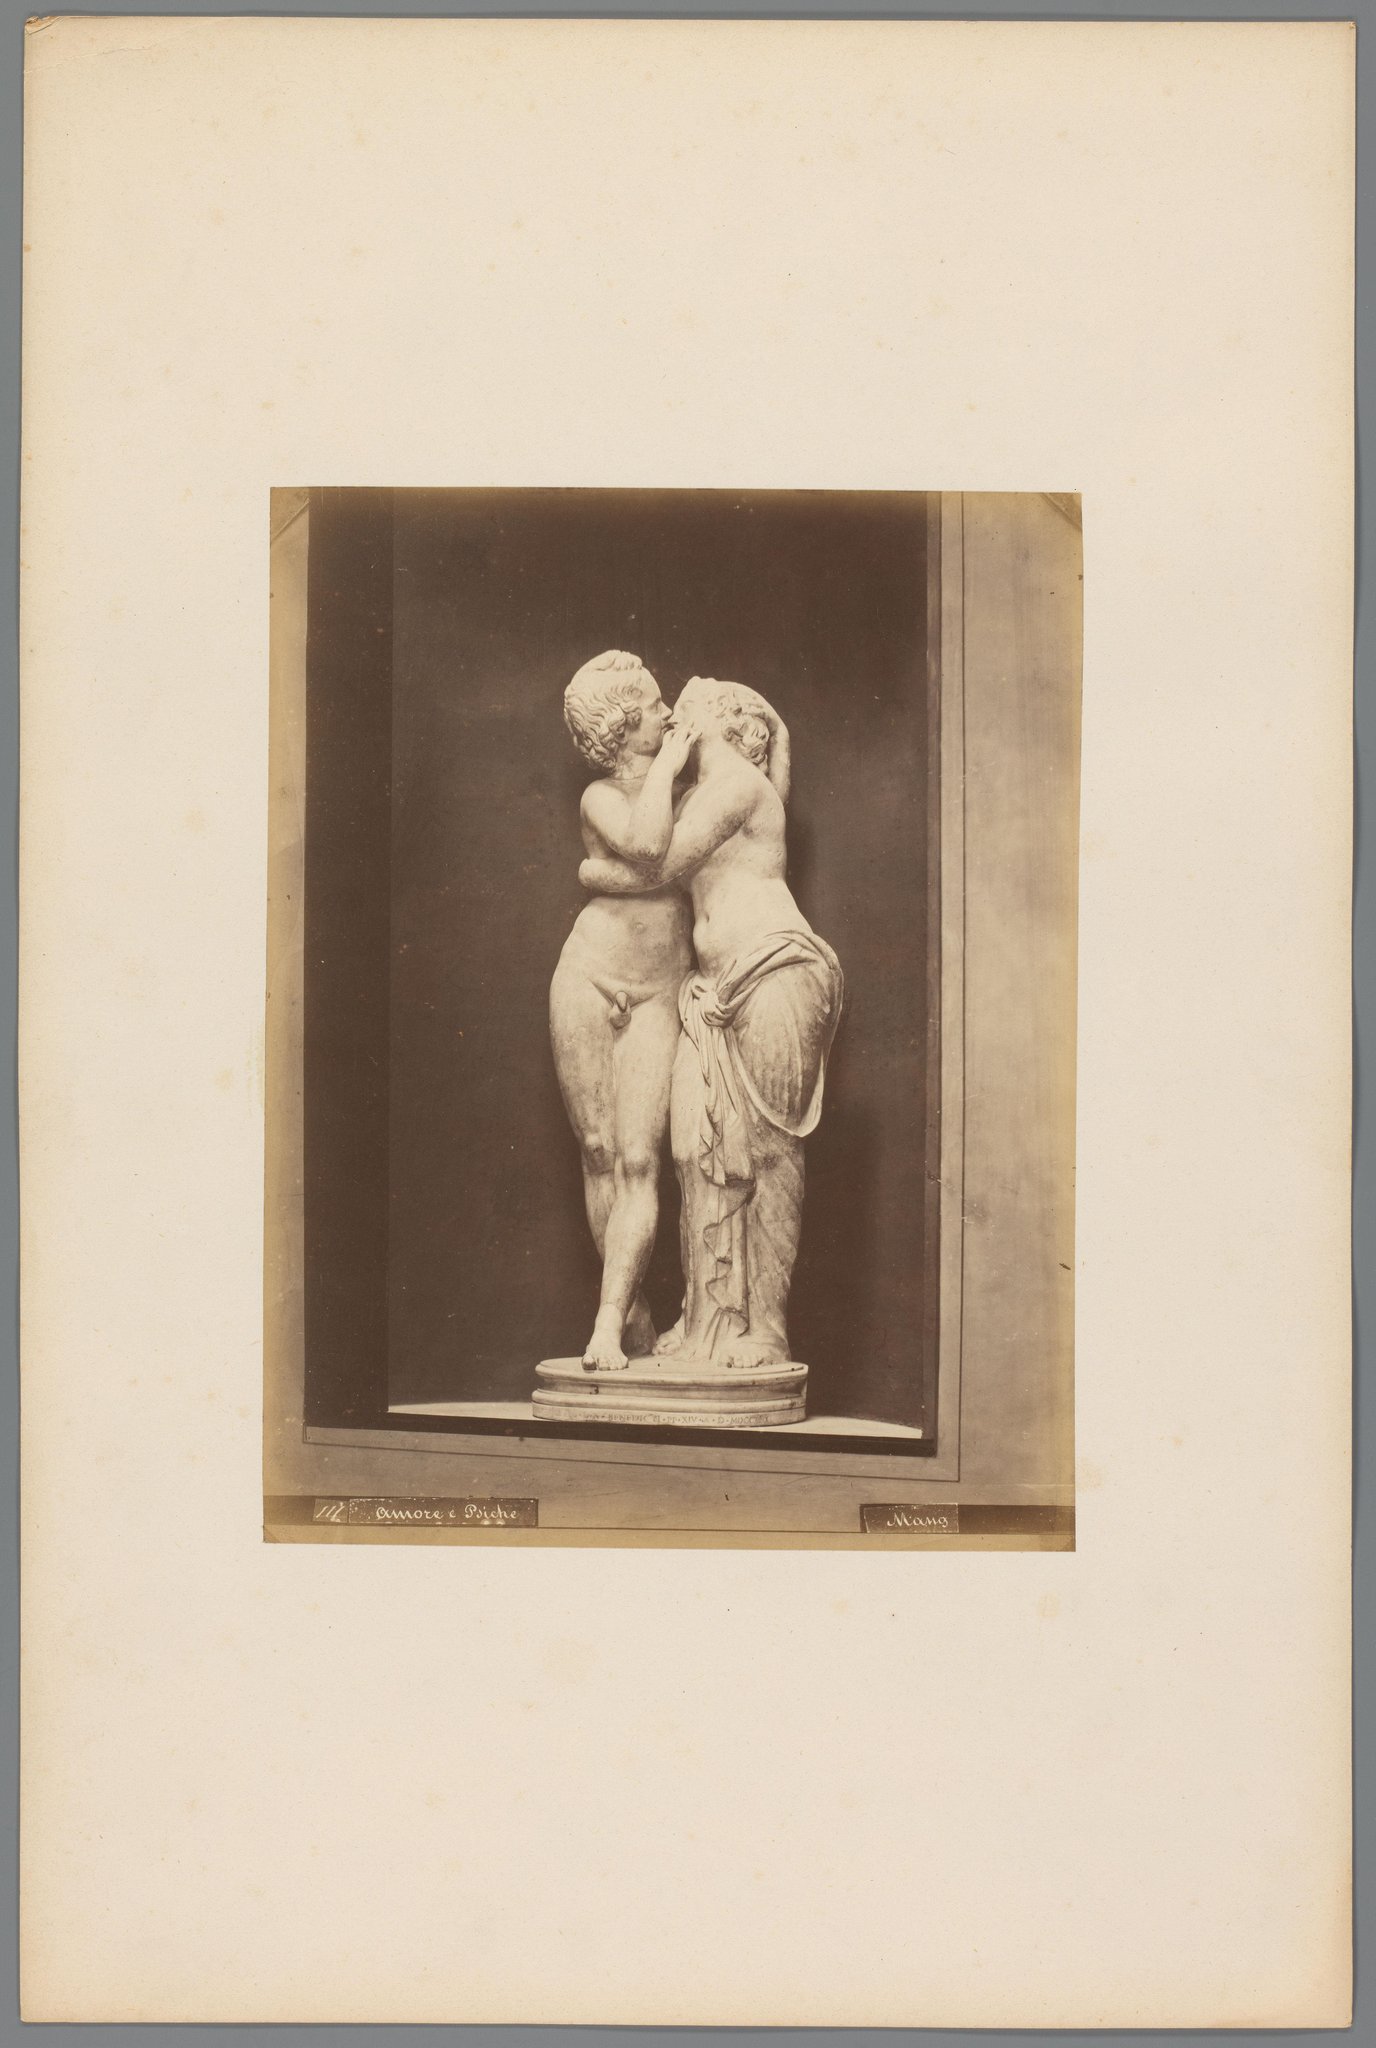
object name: photograph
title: Sculptuur van Amor en Psyche in de Capitolijnse Musea, Italië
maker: michèle mang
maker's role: fotograaf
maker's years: 1840-1909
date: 1863-1887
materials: cardboard, paper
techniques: albumen print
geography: rome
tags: piece of sculpture, reproduction of a piece of sculpture, cupid and psyche as lovers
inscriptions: number: ‘111’